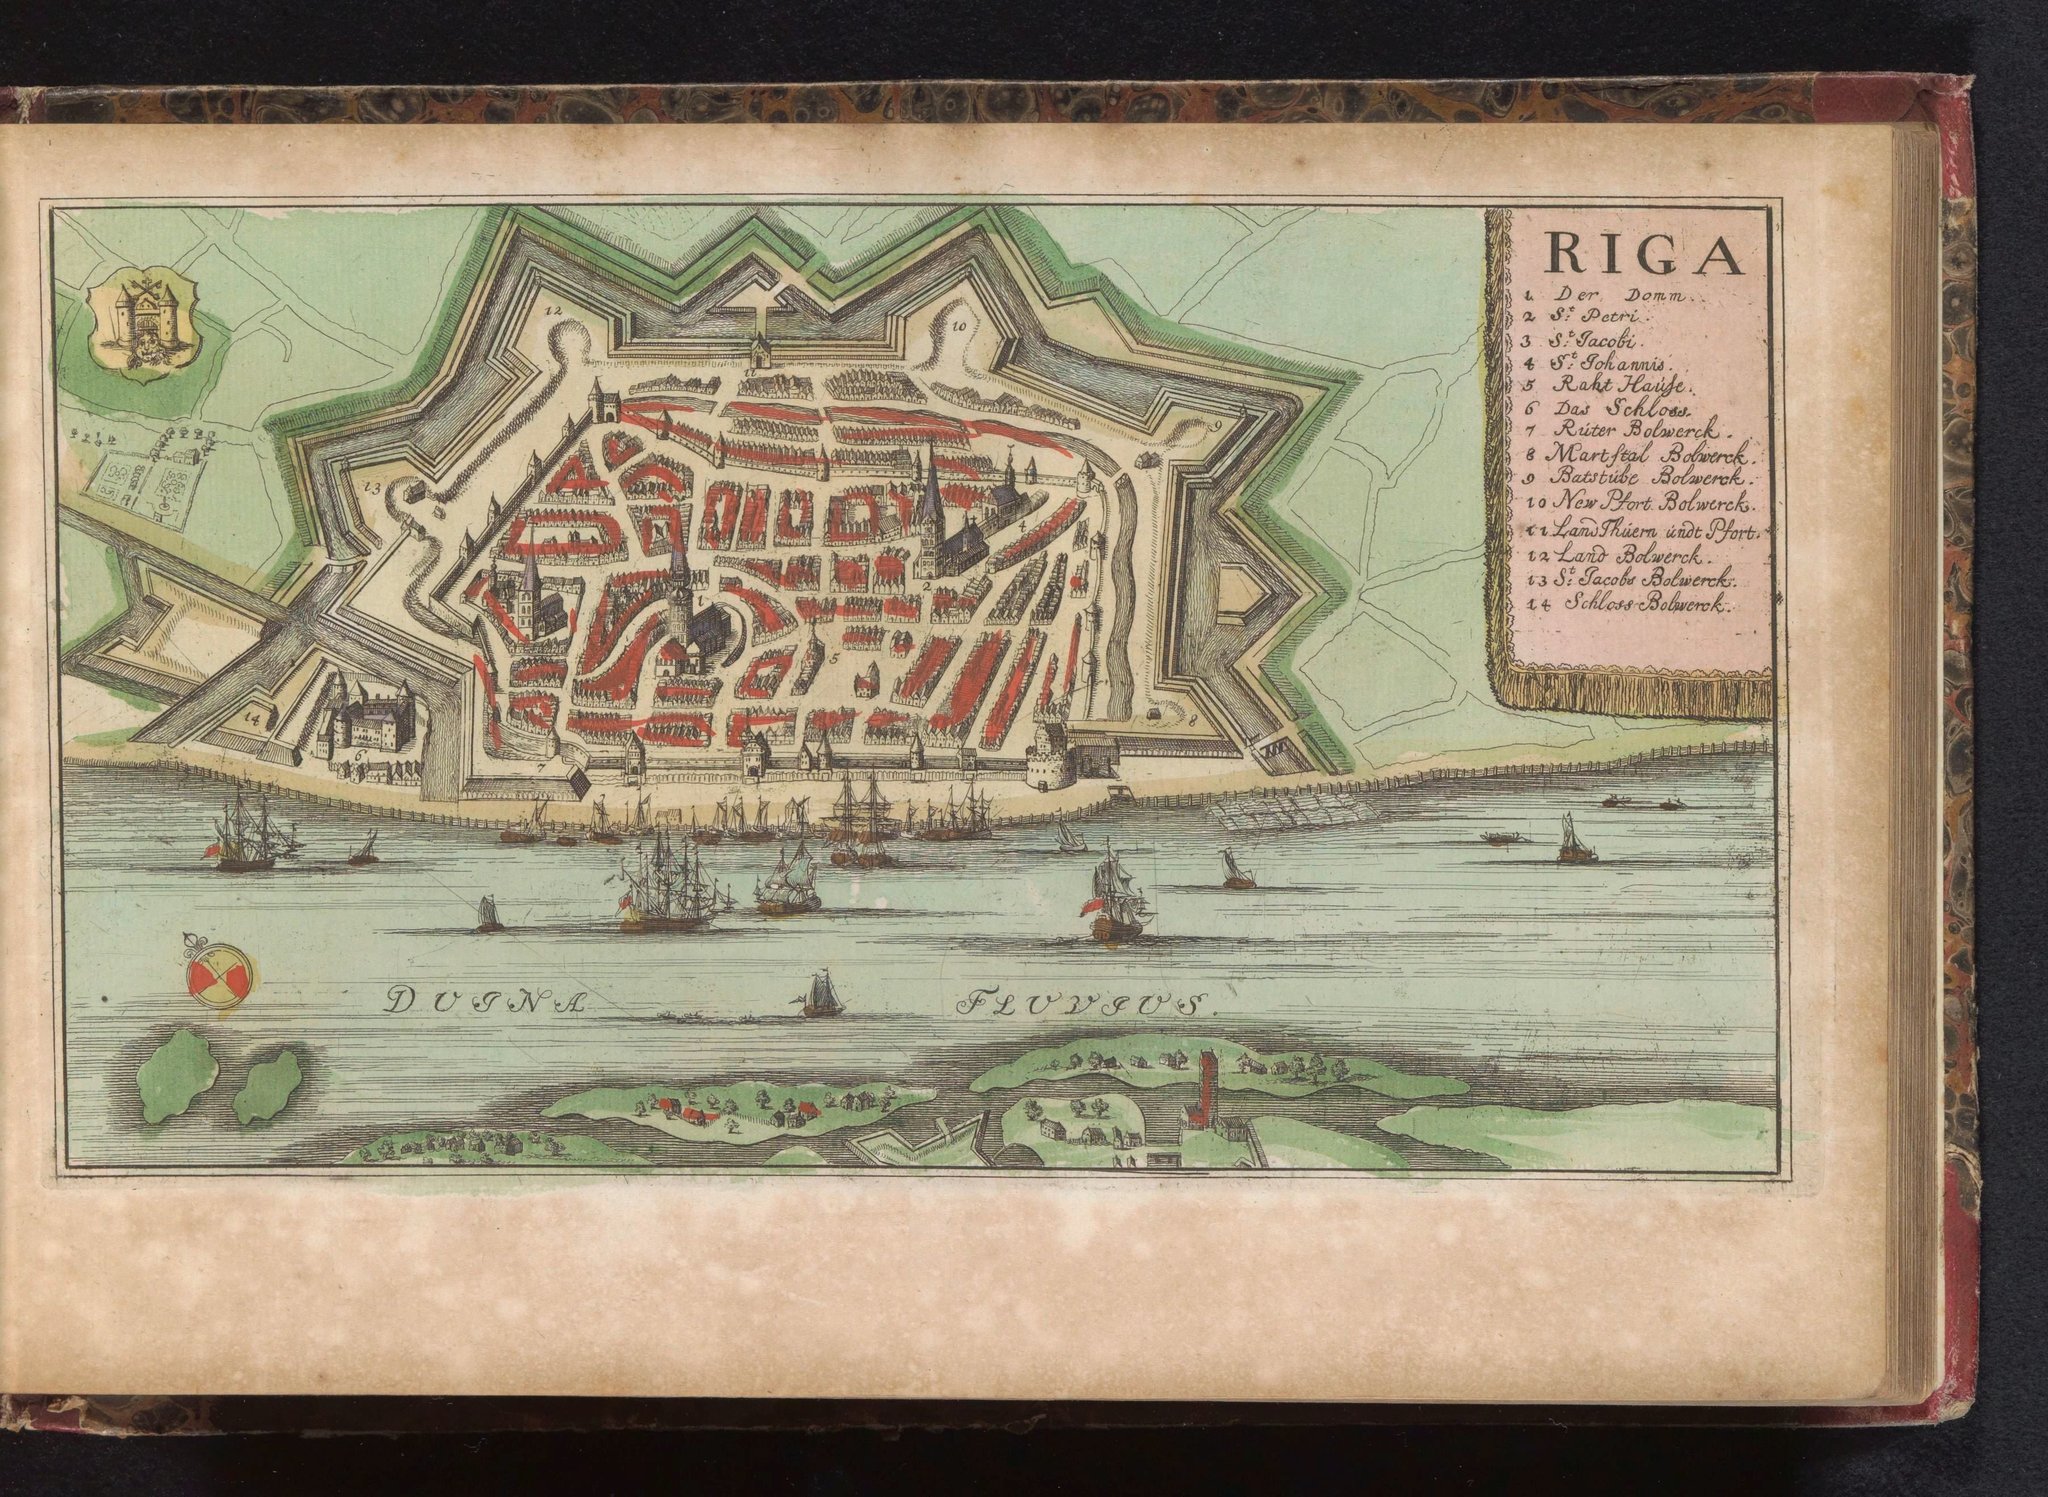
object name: print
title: Plattegrond van Riga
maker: Anonymous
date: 1735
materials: paper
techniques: etching, hand coloring, lacquer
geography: amsterdam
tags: maps of cities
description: Plattegrond in vogelvlucht van de stad Riga, op de voorgrond de rivier Dvina. Onderdeel van een atlas met 223 kaarten van landen en steden en oorlogstaferelen in Europa in de periode ca. 1690-1735.